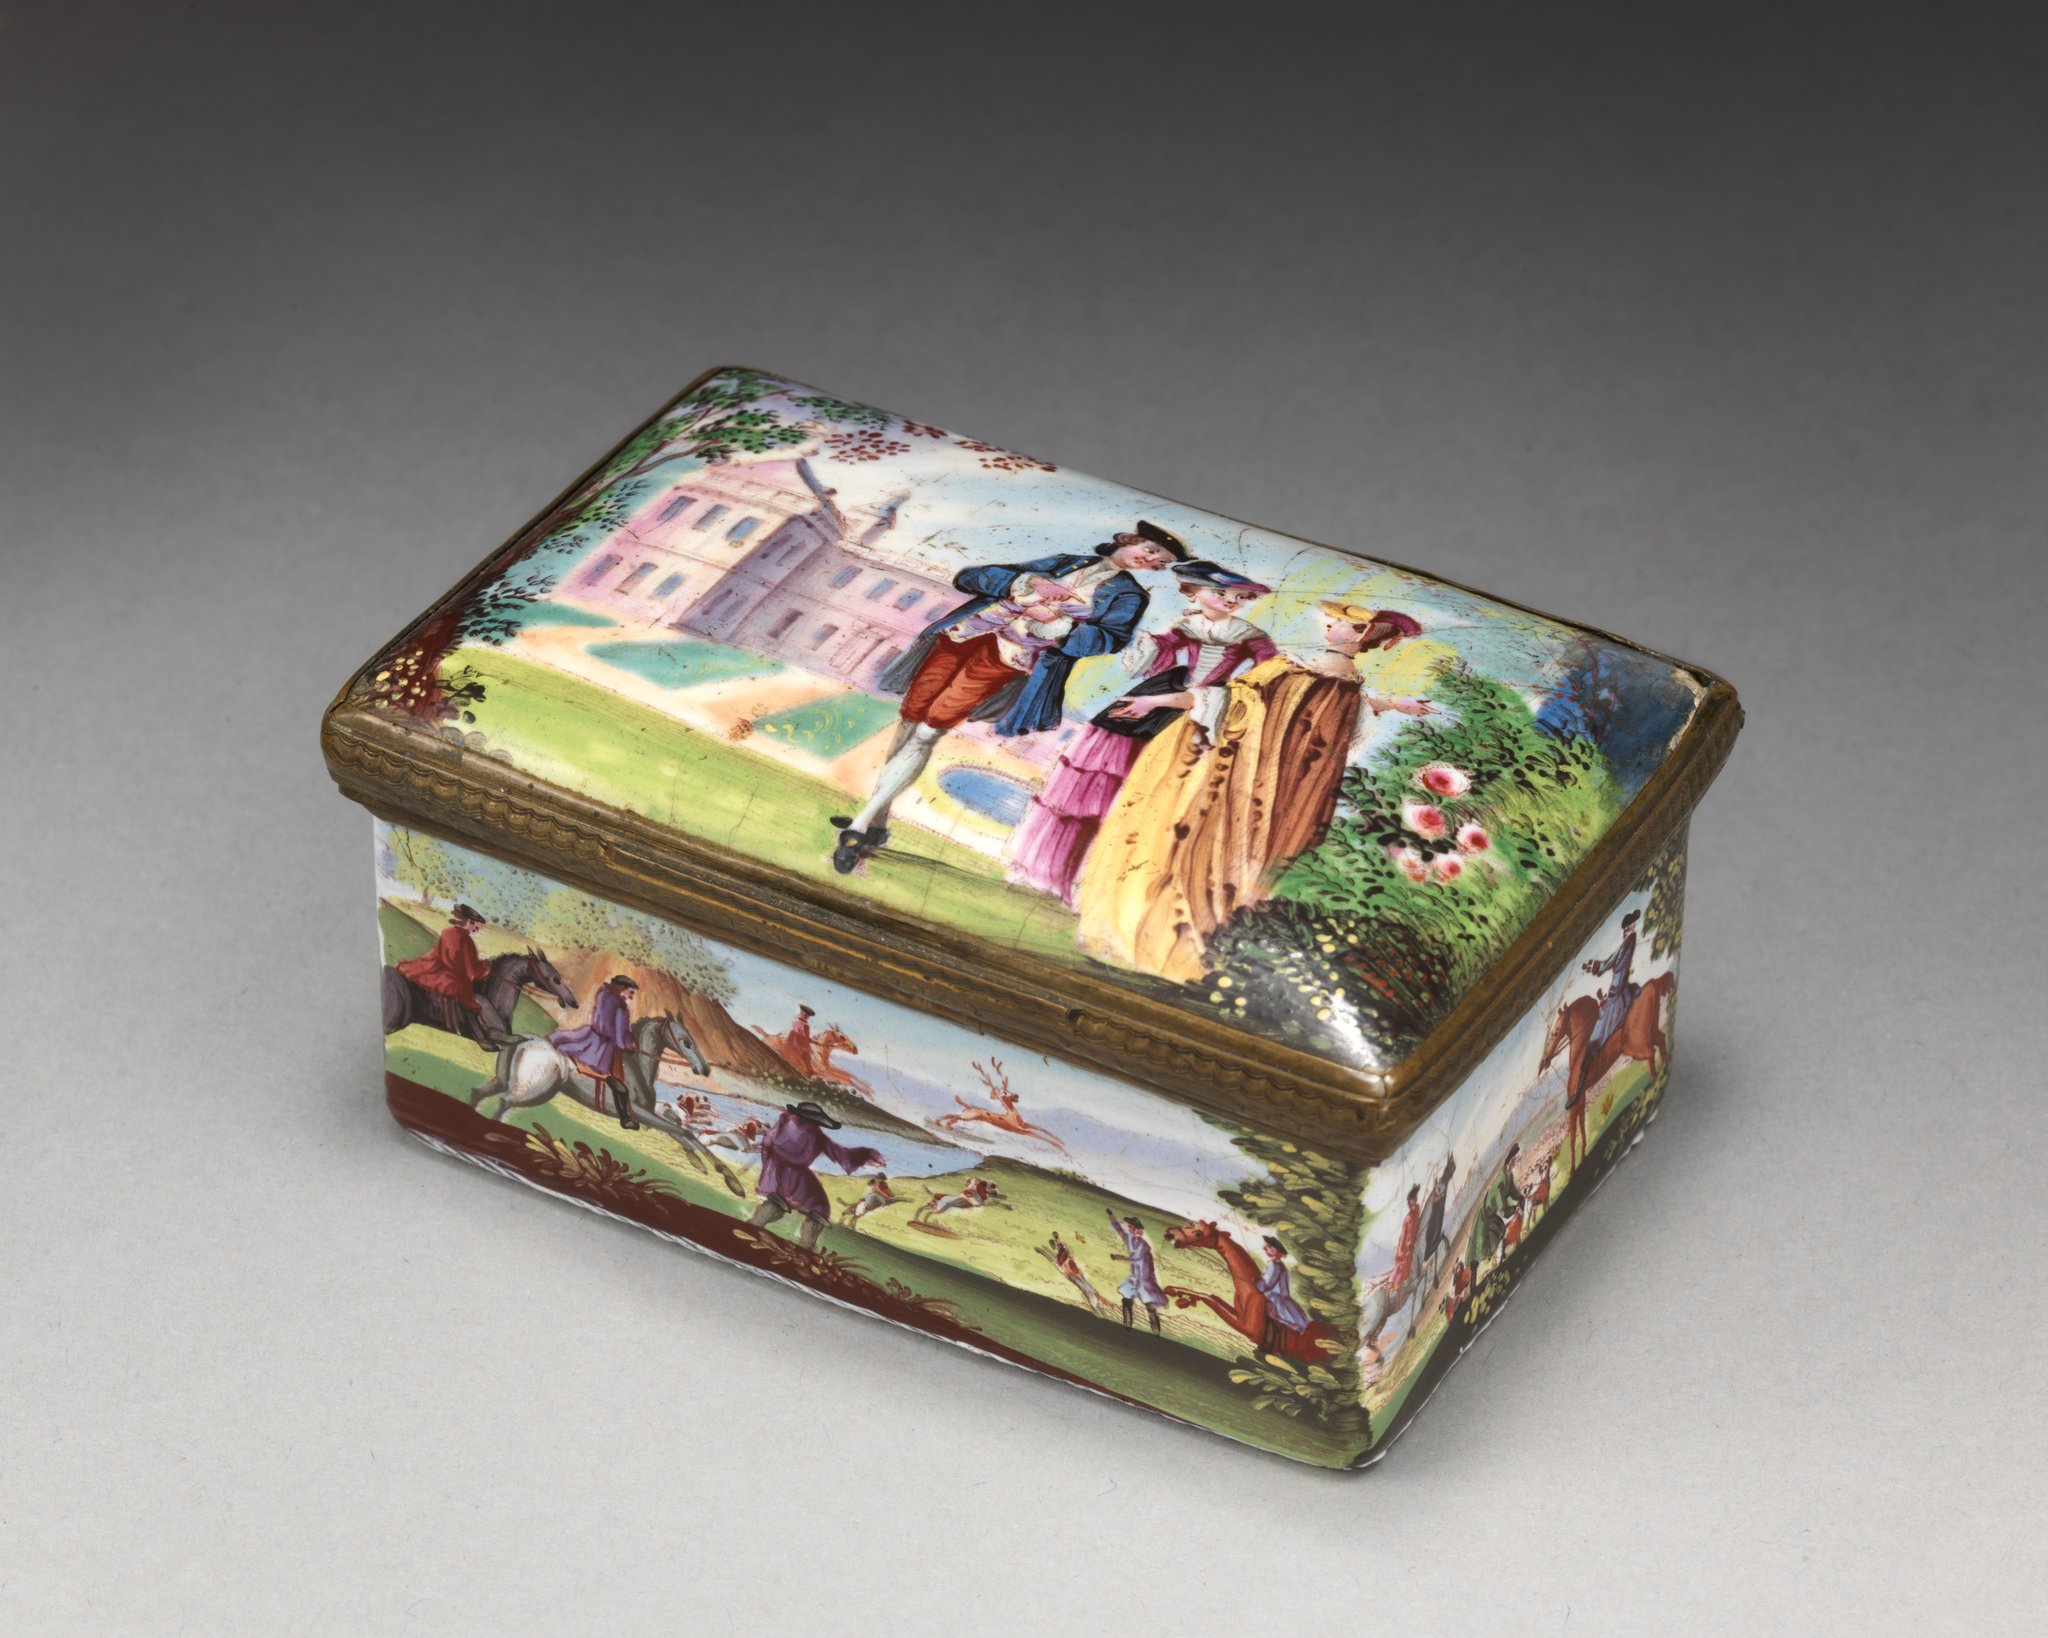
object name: snuffbox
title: Snuffbox with gallant and two ladies on lid, stag hunt on sides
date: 1755-1760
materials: copper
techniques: enamel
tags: houses,men,women,horses